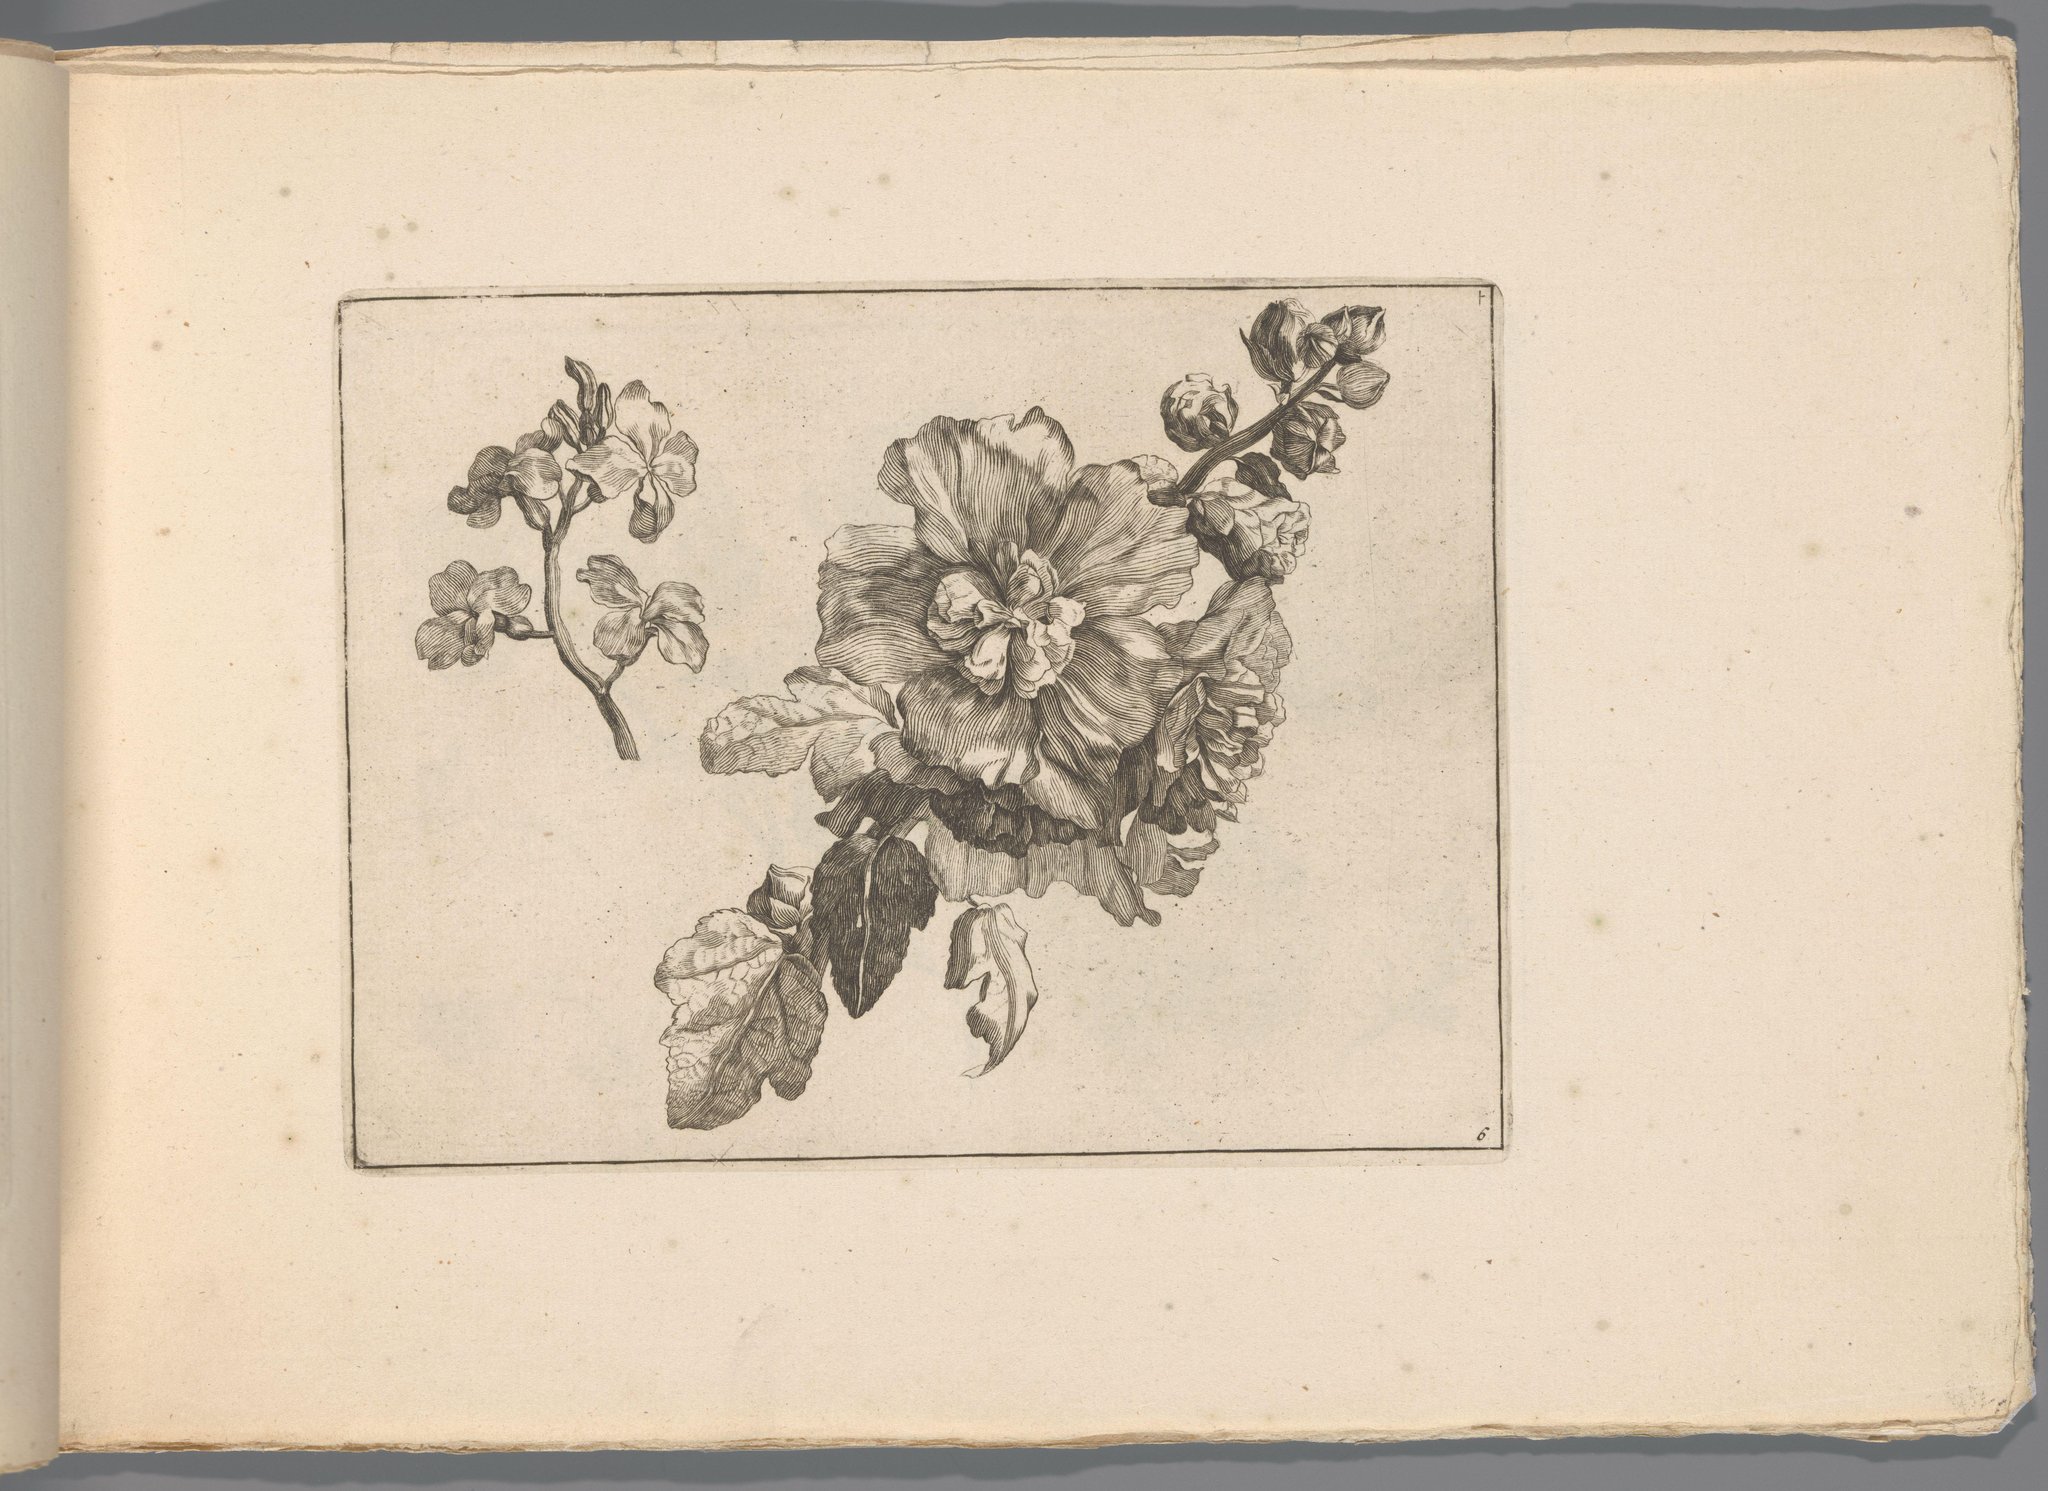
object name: ornament print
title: Dubbelbloemige stokroos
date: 1670-1726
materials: paper, fiber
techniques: engraving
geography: amsterdam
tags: flowers: rose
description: De prent maakt deel uit van een samengebonden, genummerde serie van elf prenten met bloemen. De serie bestond oorspronkelijk waarschijnlijk uit twaalf prenten. Het fonds- of serienummer is nr. 60.